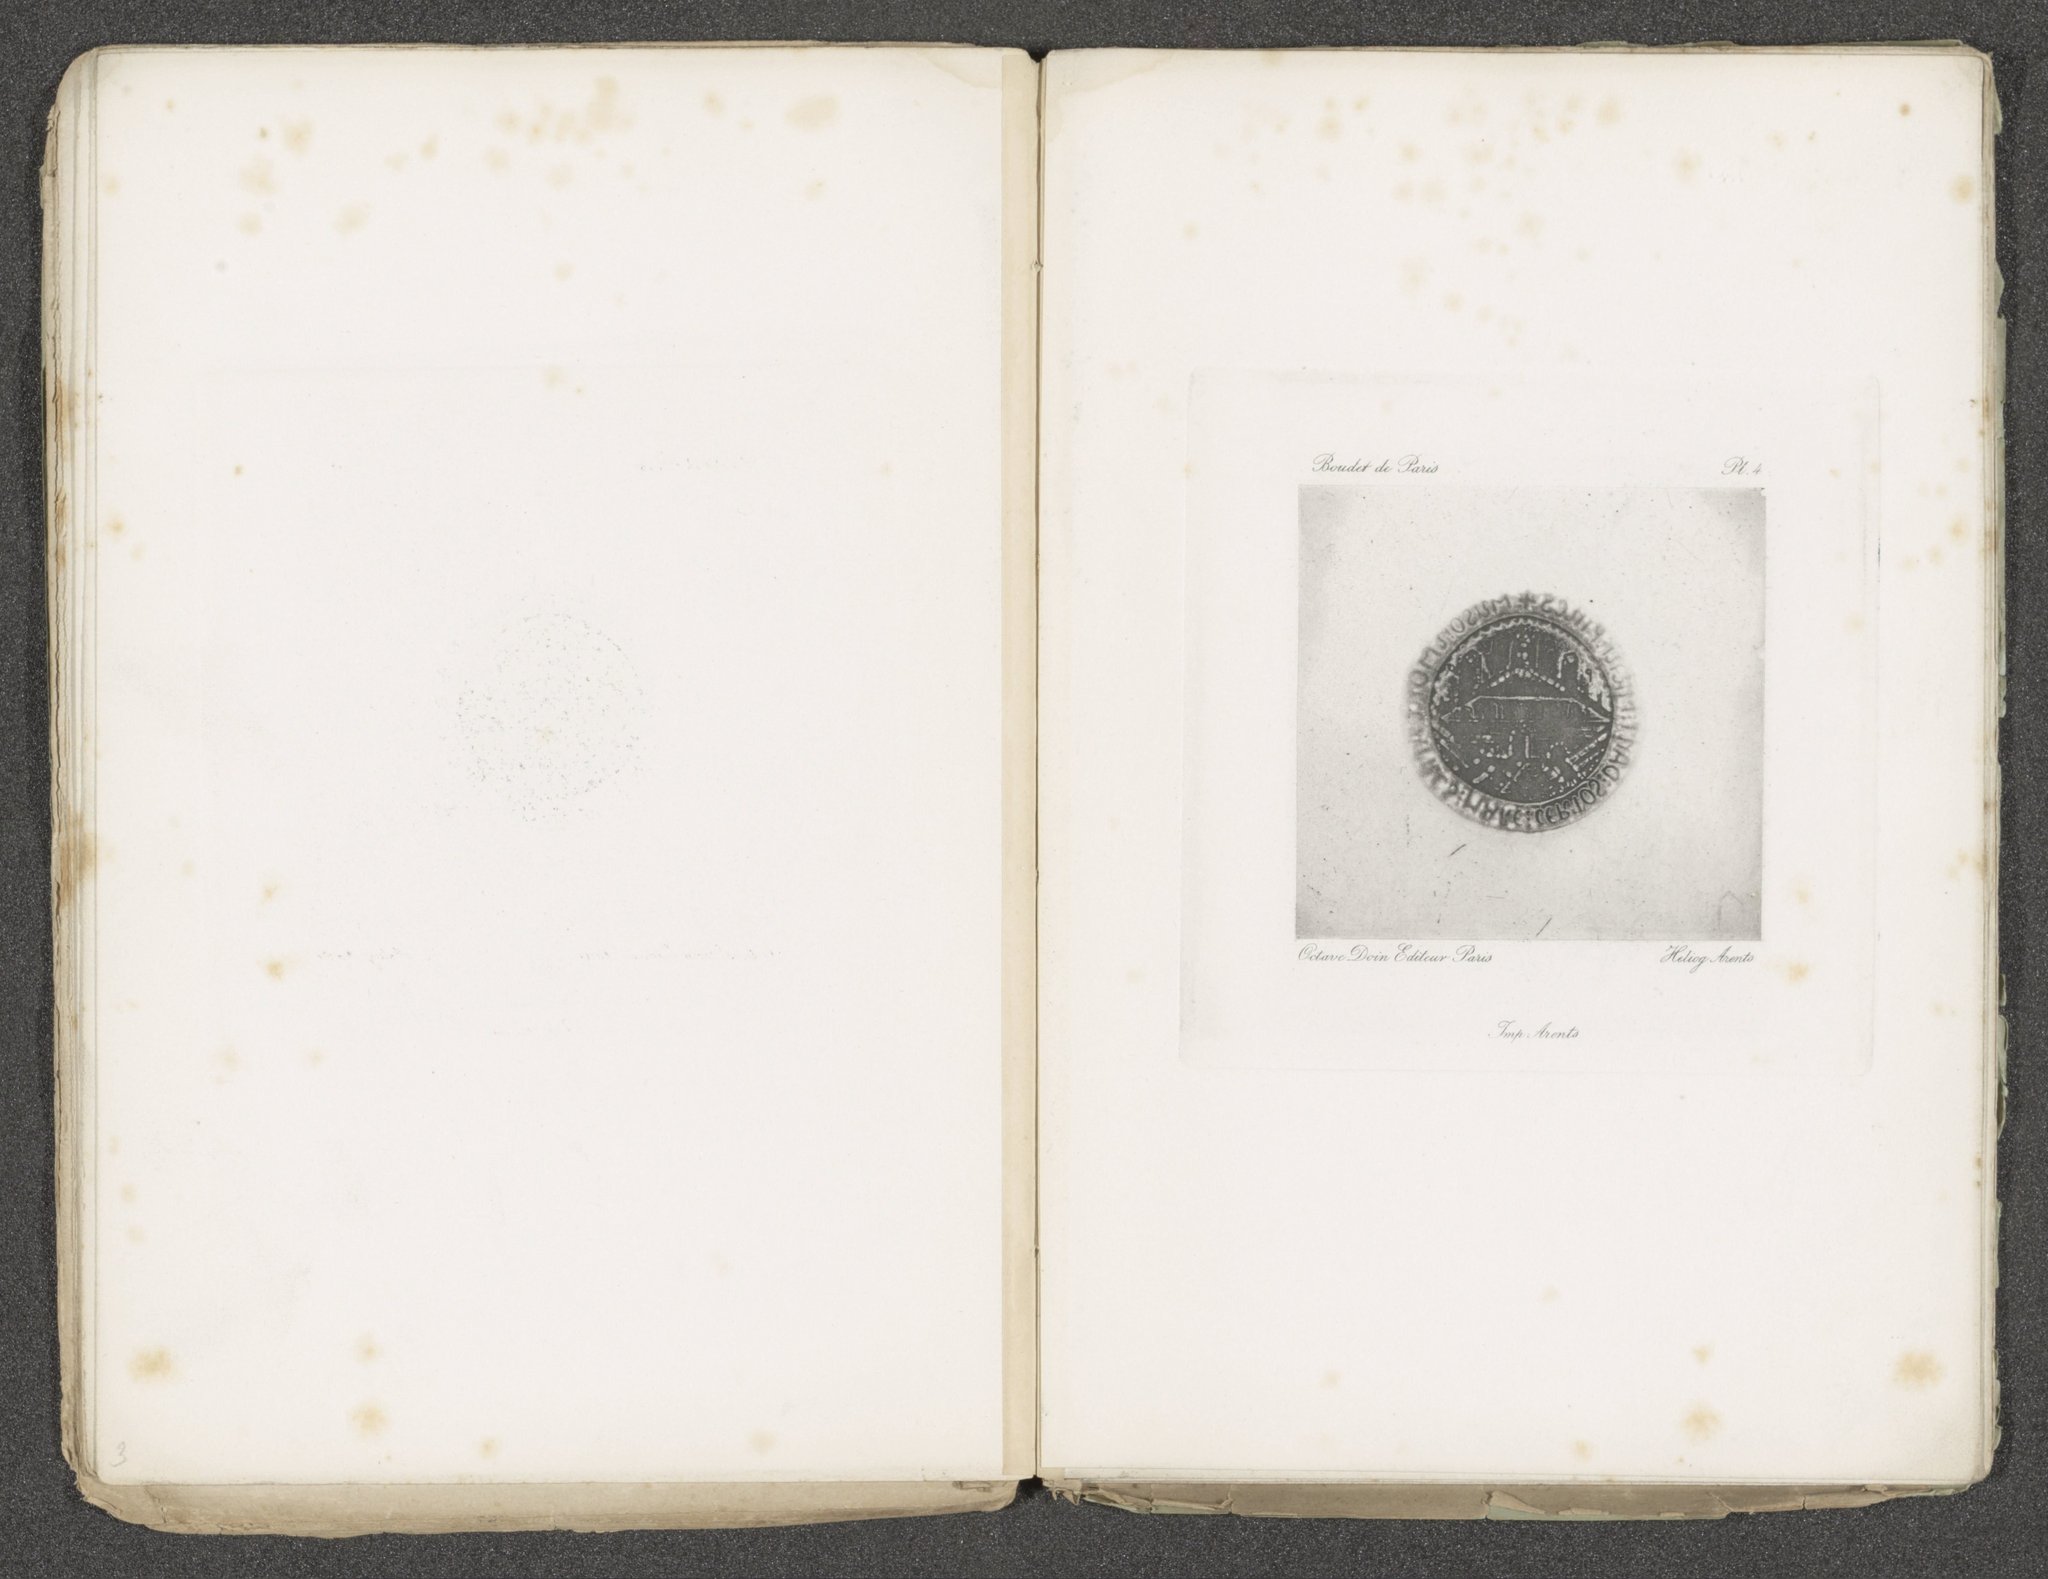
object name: page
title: Munt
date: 1876-1886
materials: paper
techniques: photoaquatint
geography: paris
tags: coin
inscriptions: number: ‘Pl. 4.’